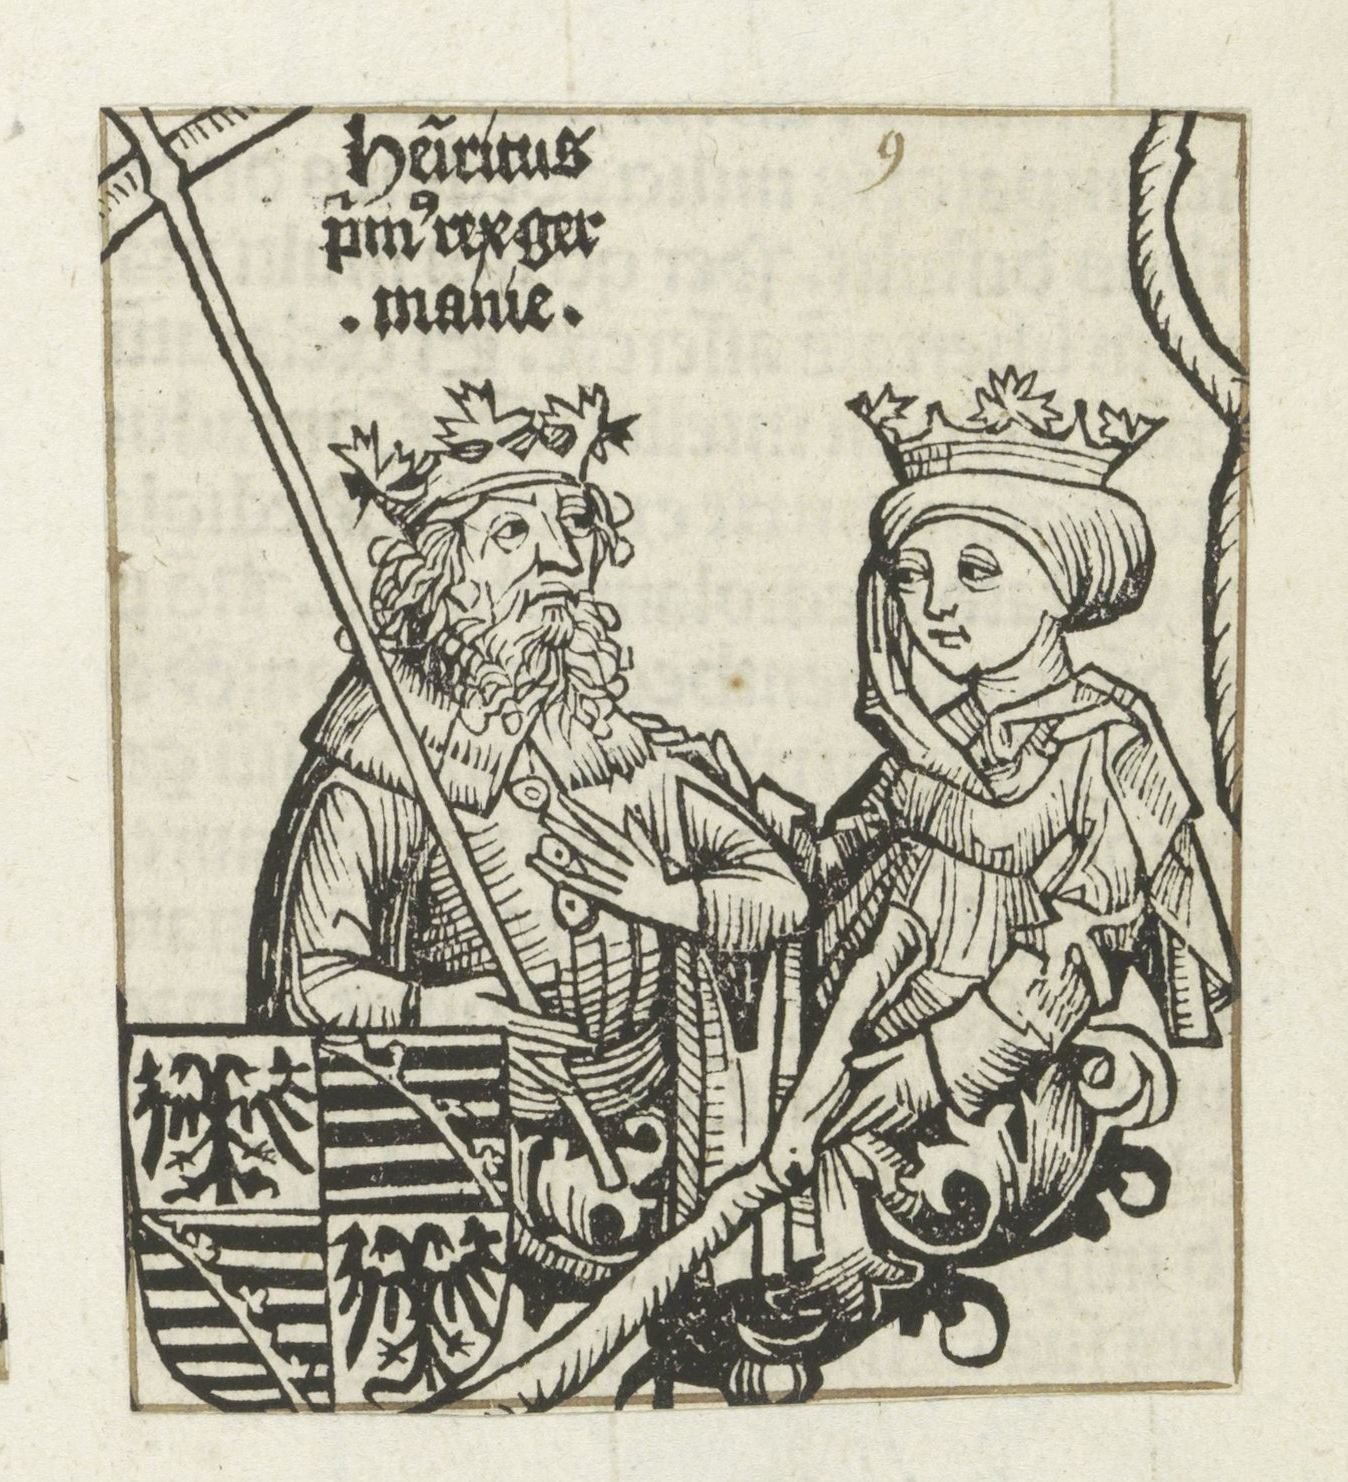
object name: album leaf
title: Hei[n]ricus p[ri]m[us] rex germanie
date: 1493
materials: paper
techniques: letterpress printing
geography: nuremberg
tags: queen, empress, etc. (wife of a ruler), king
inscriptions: inscription: ‘9’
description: Een bloemkelk met een koning en zijn vrouw. De man heeft een lans in zijn handen. Daarbij een wapenschild. De voorstelling is onderdeel van de stamboom van keizer Hendrik II de Heilige in de Liber Chronicarum. De tekst en het schild identificeren de personen als Hendrik de Vogelaar en zijn vrouw. De prent maakt deel uit van een album.